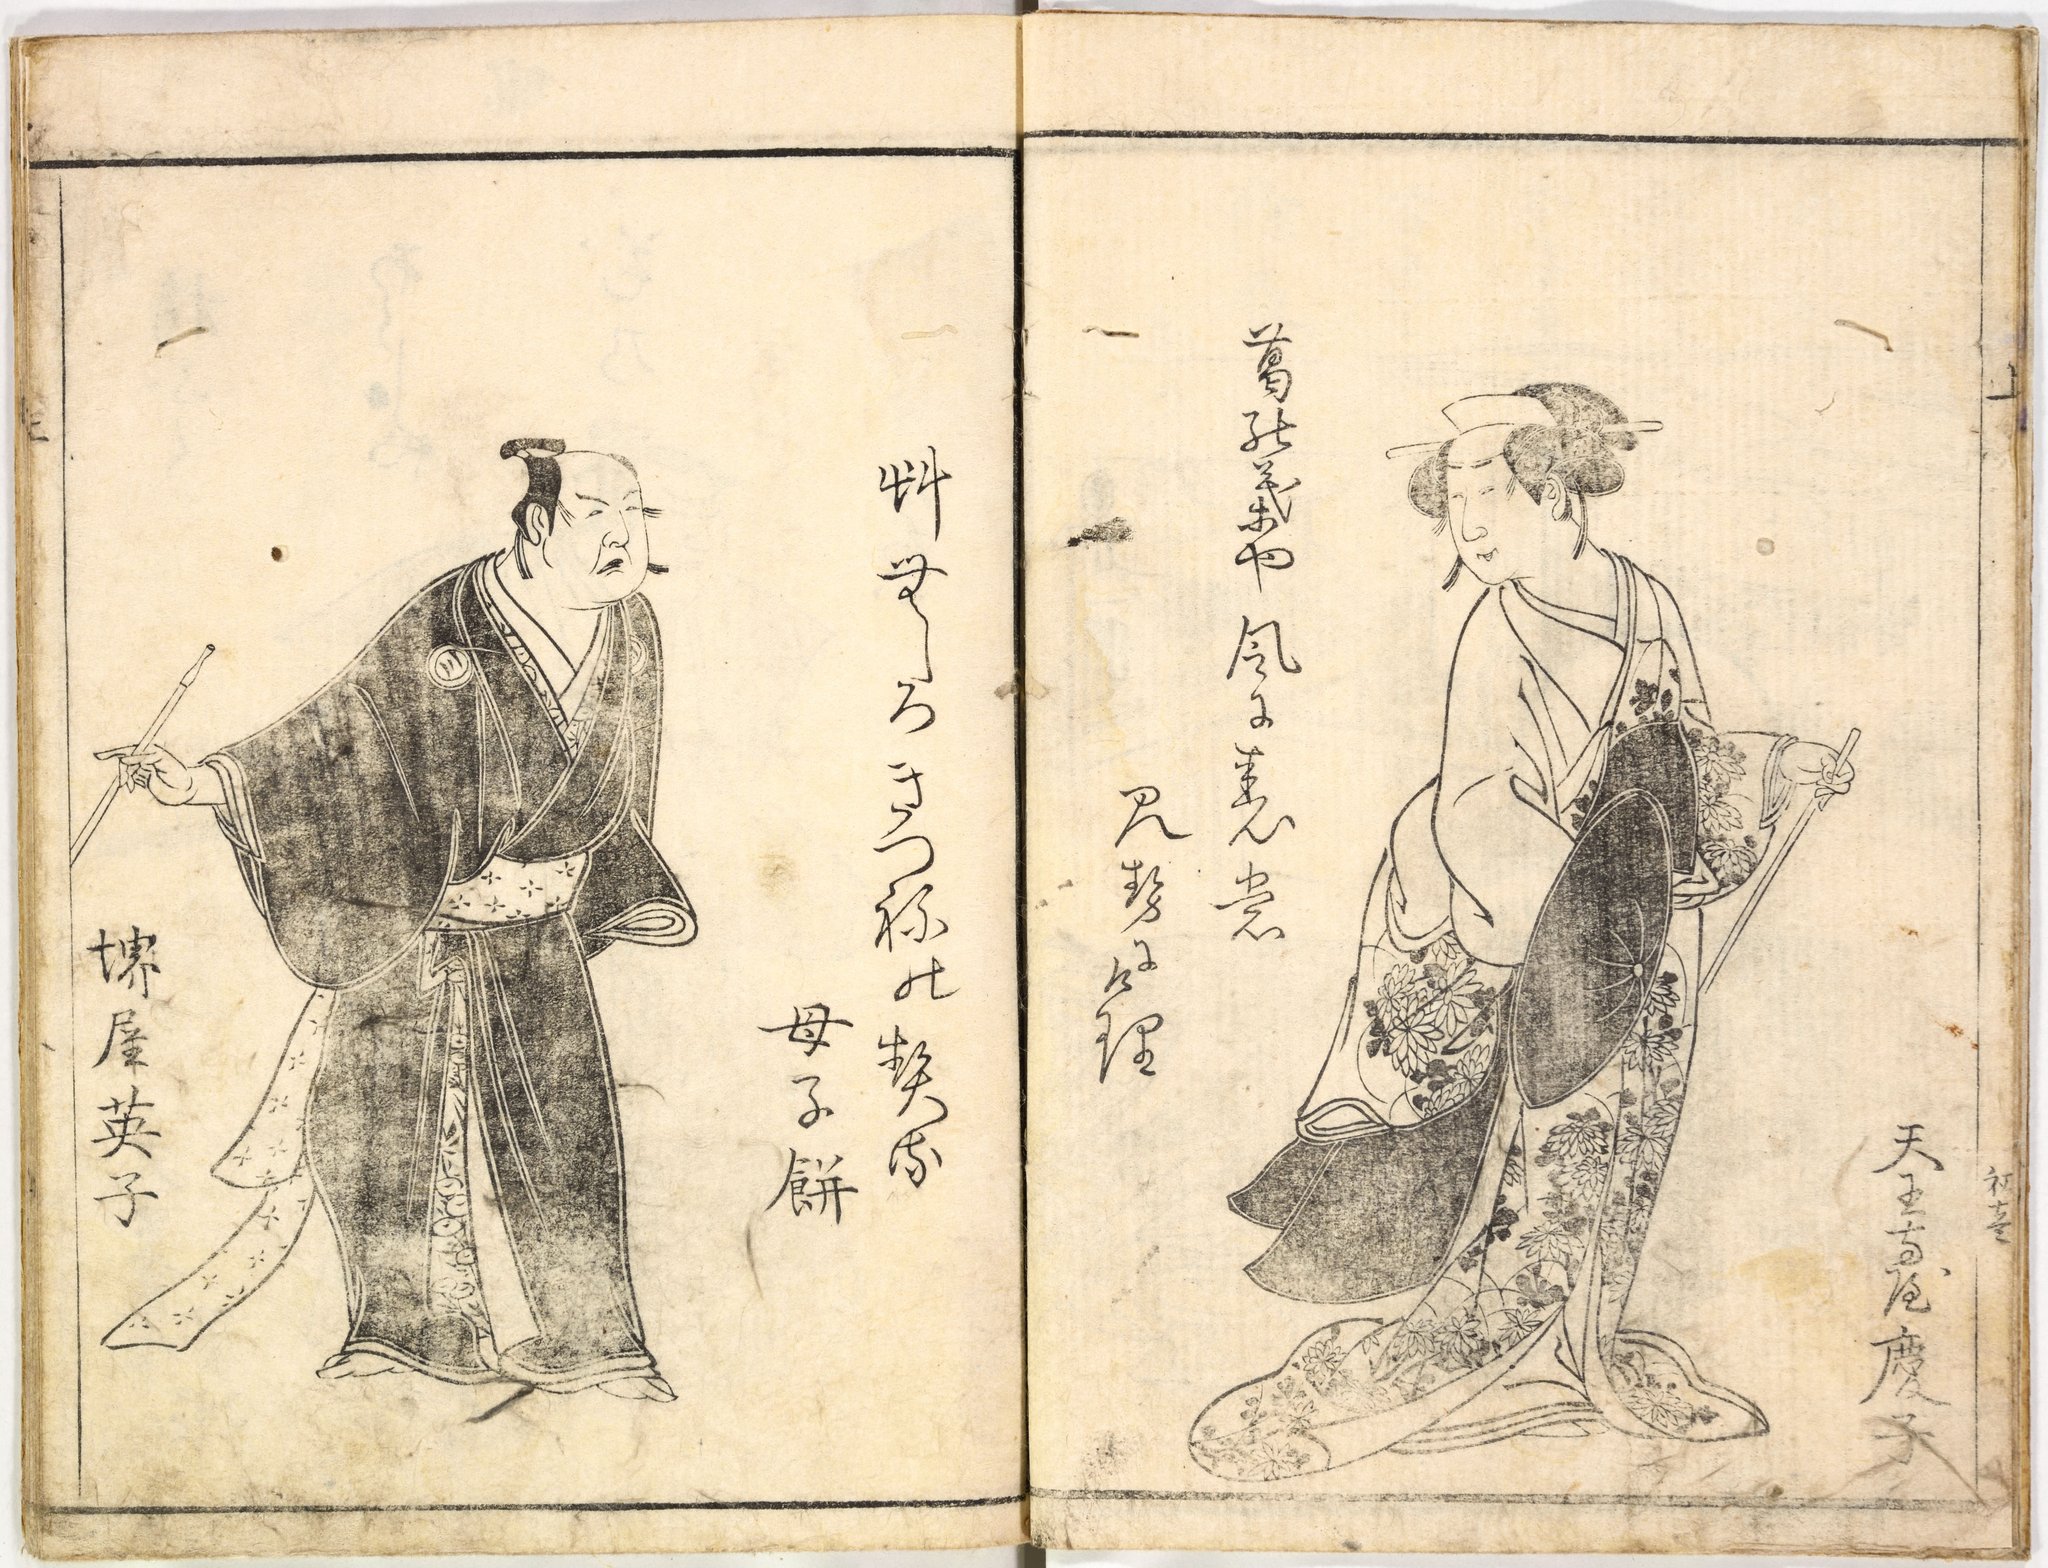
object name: illustrated book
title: A Celebration of Actors (Yakusha mono iwai)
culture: japanese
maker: ryūkōsai jokei 流光斎如圭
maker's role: artist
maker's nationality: japanese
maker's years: 1777-1809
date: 1784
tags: men,women,actors